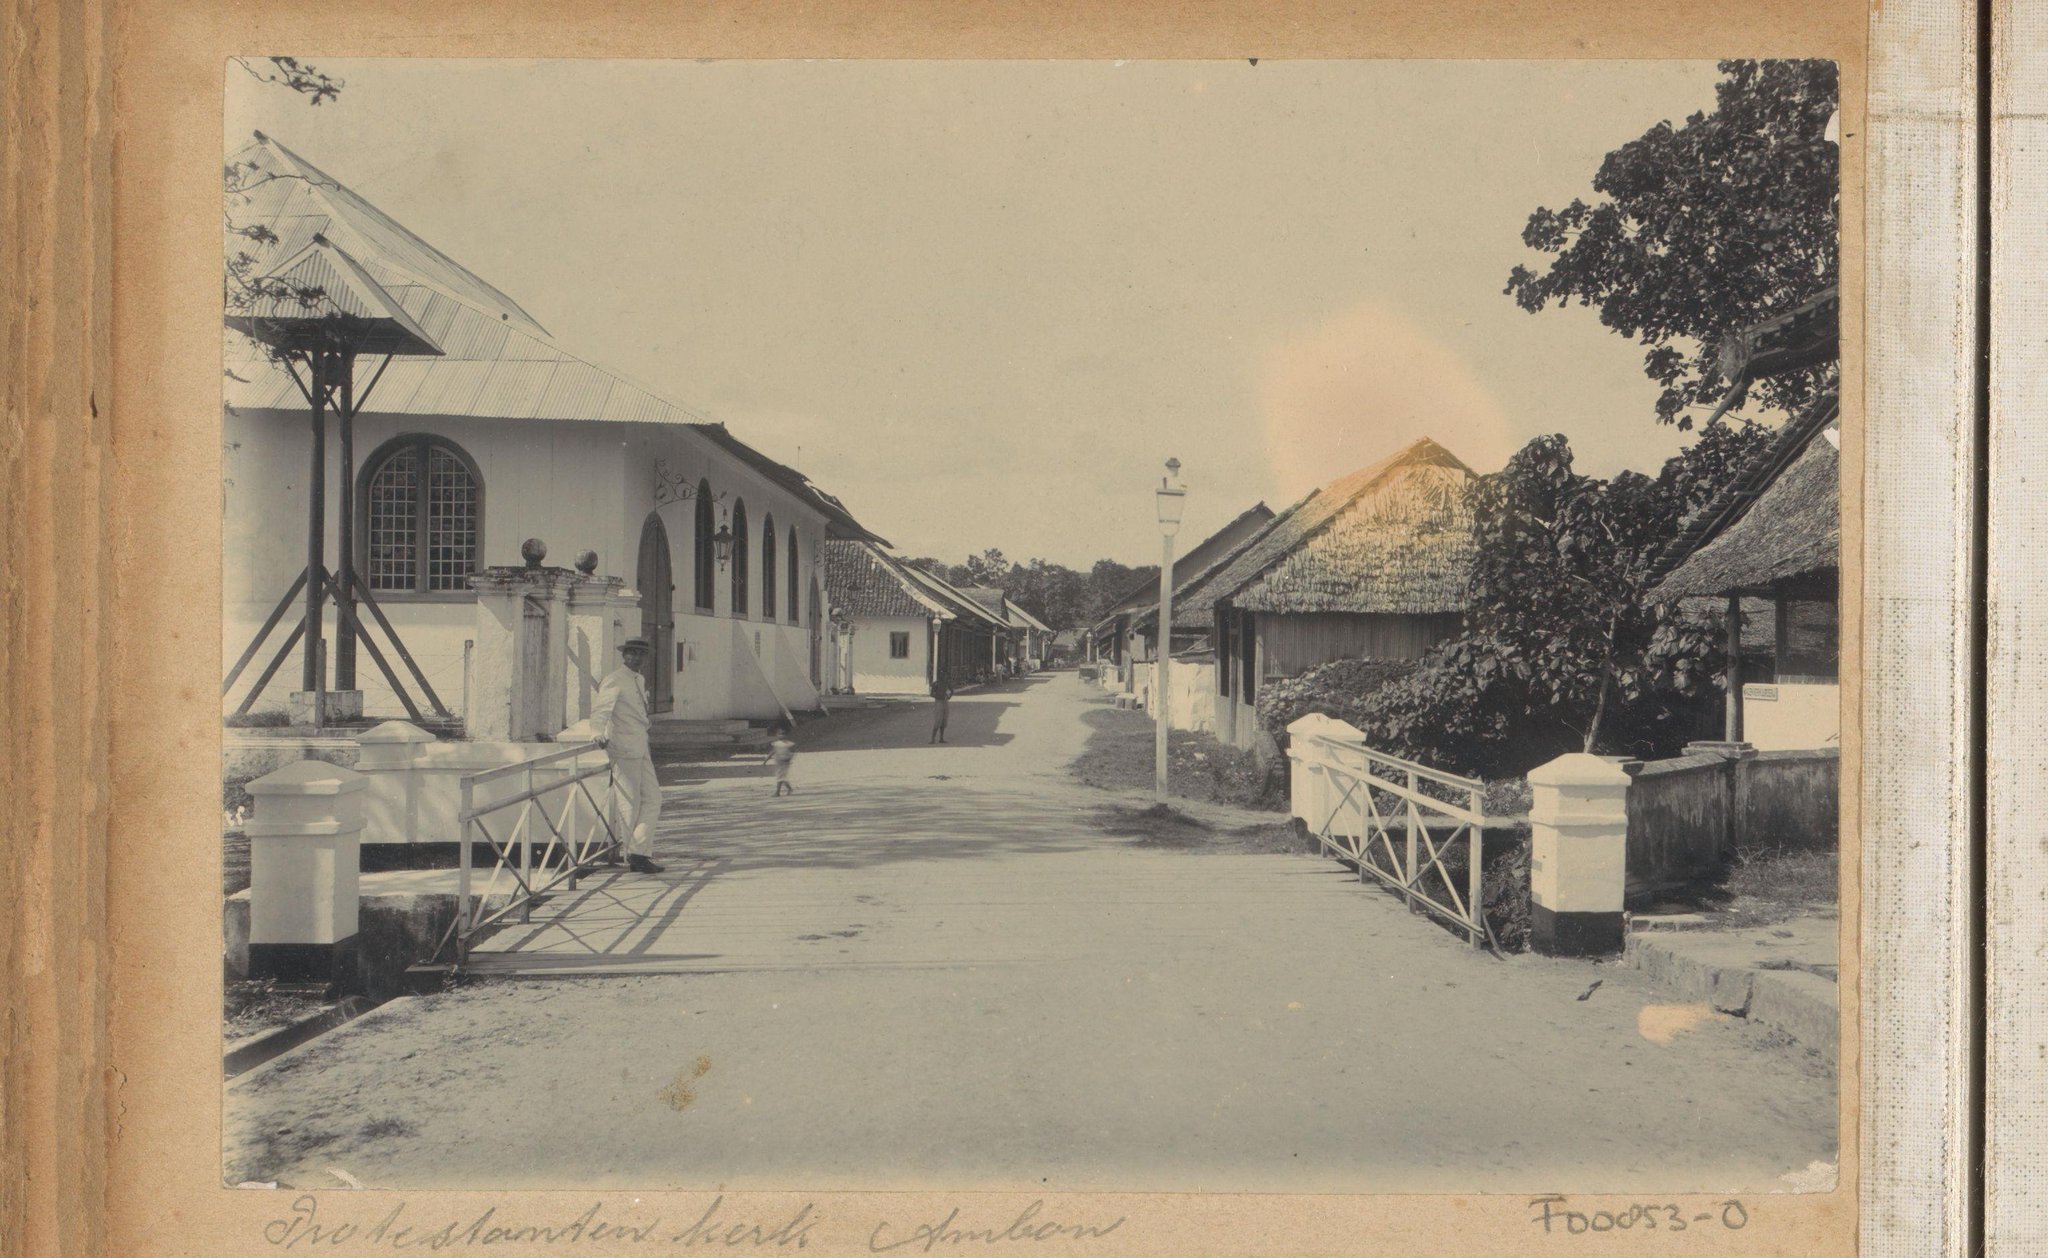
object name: album leaf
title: Straatgezicht bij een protestantse kerk op Ambon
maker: Anonymous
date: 1900-1920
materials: cardboard, paper, photographic support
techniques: gelatin silver print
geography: ambon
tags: church (exterior), street (+ city(-scape) with figures, staffage), dutch east indies, the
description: Onderdeel van Reisalbum met foto's van Ambon.